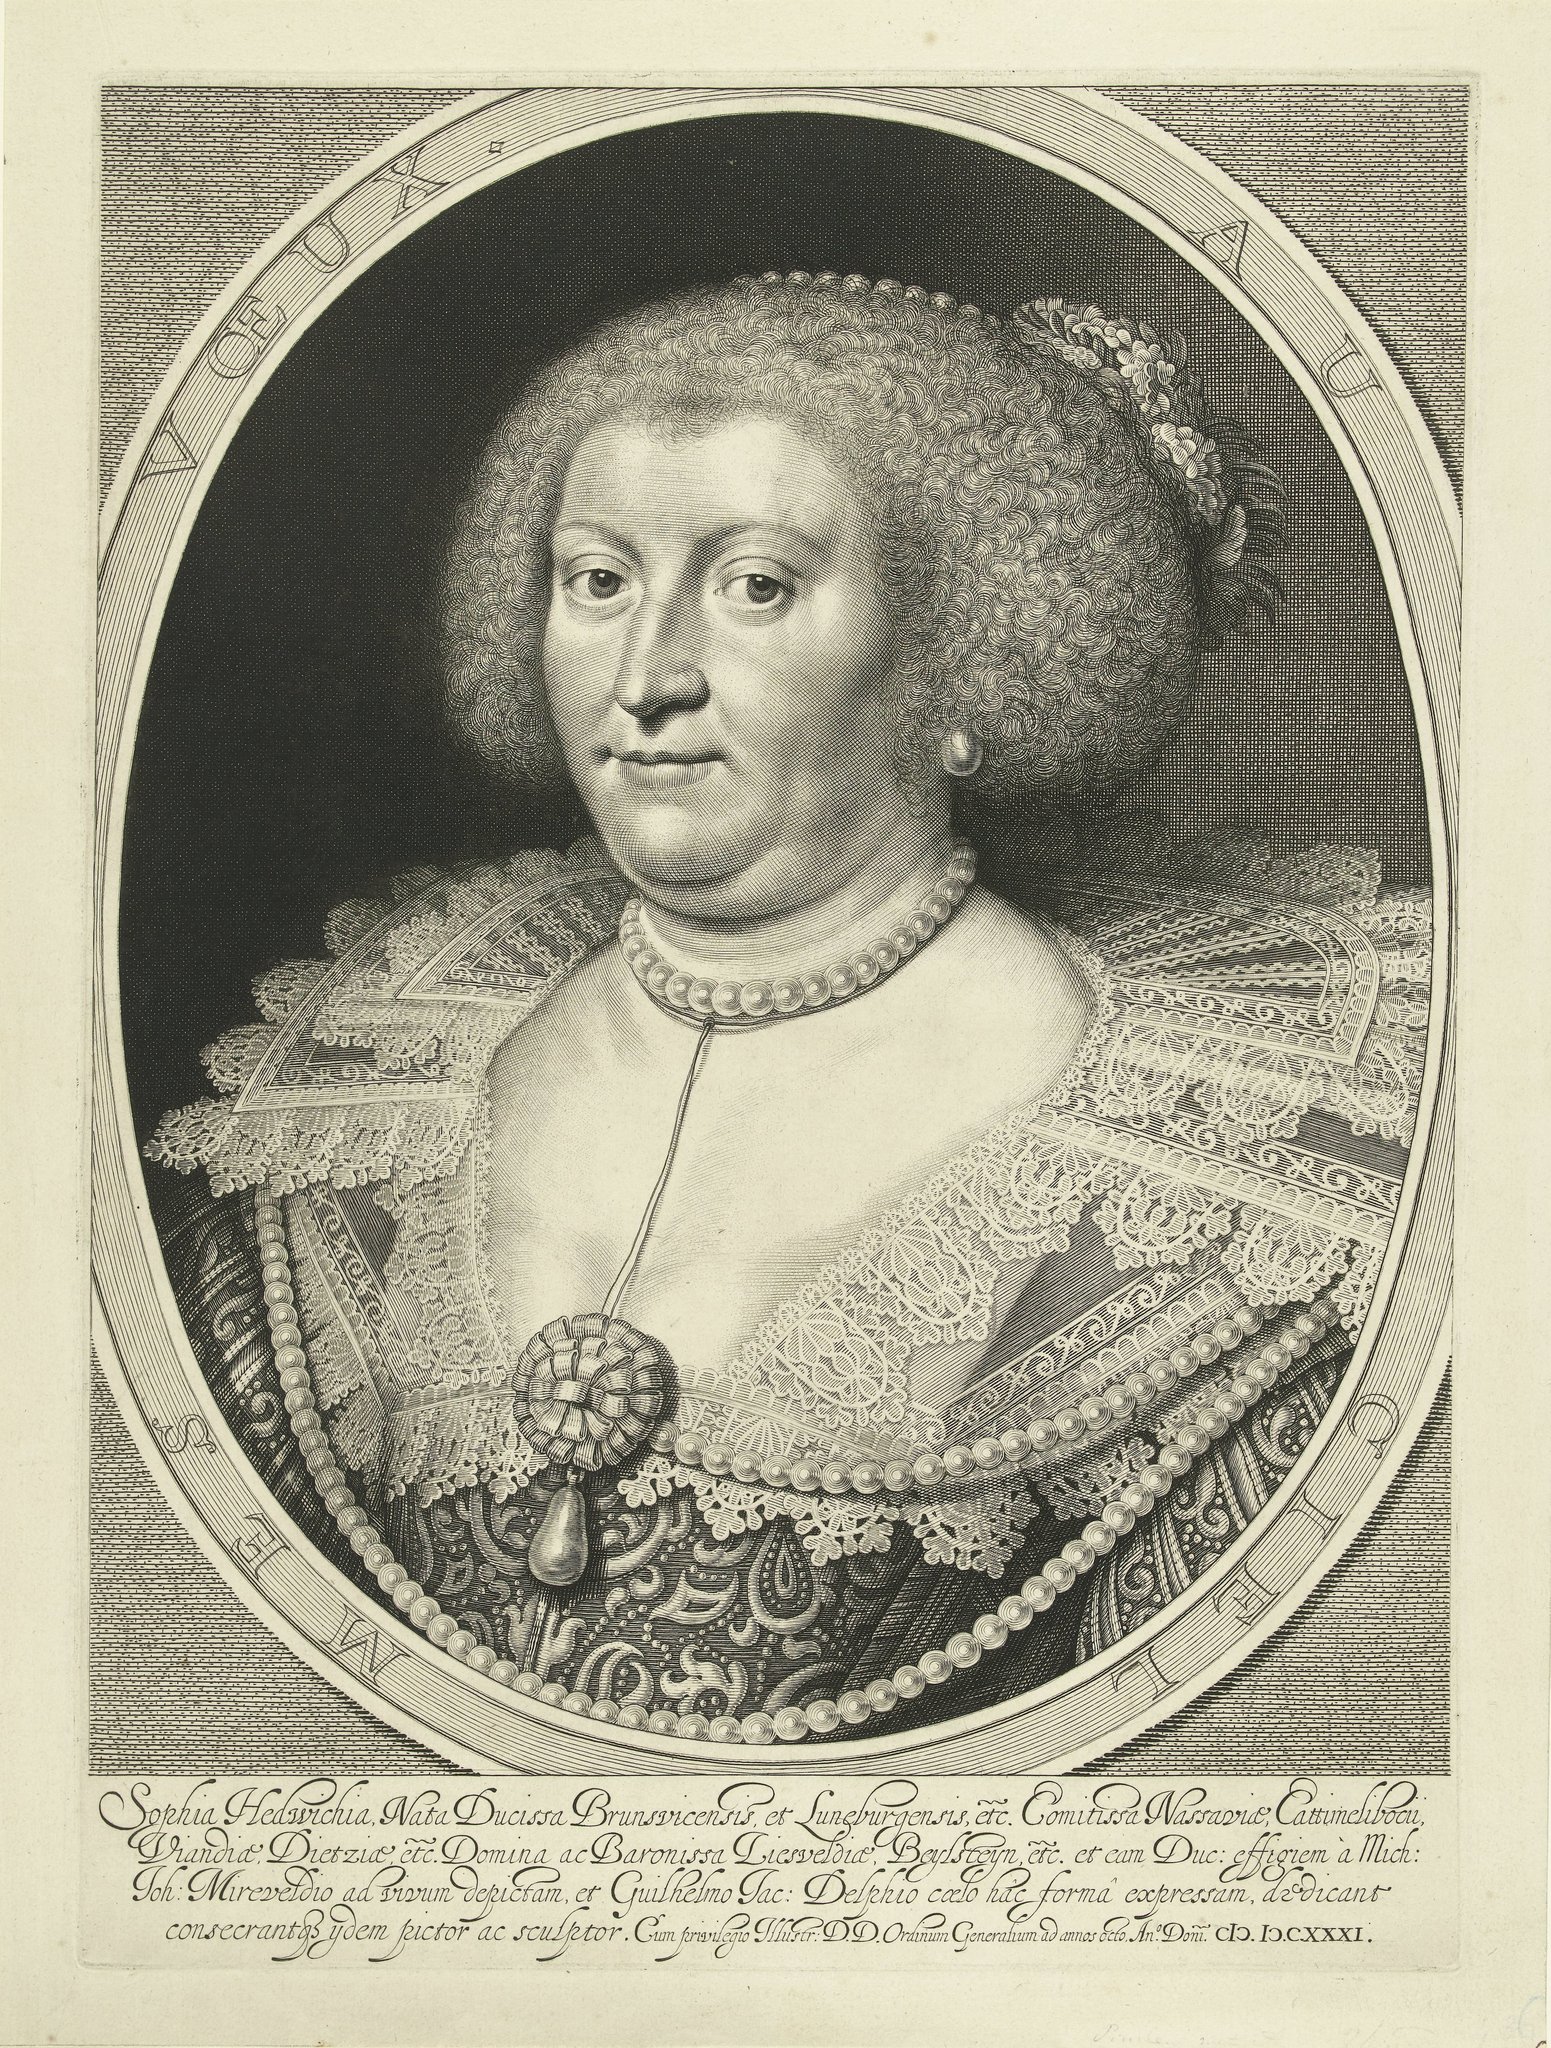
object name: print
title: Portret van Sophia Hedwig van Brunswijk-Wolfenbüttel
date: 1631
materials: paper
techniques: engraving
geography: delft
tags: sophia hedwig van brunswijk-wolfenbüttel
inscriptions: collector's mark: Lugt 2228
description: Portret van Sophia Hedwig van Brunswijk-Wolfenbüttel, borststuk met kanten kraag en parelsnoeren. In ovale omlijsting met motto, Latijns opschrift in vier regels in ondermarge.